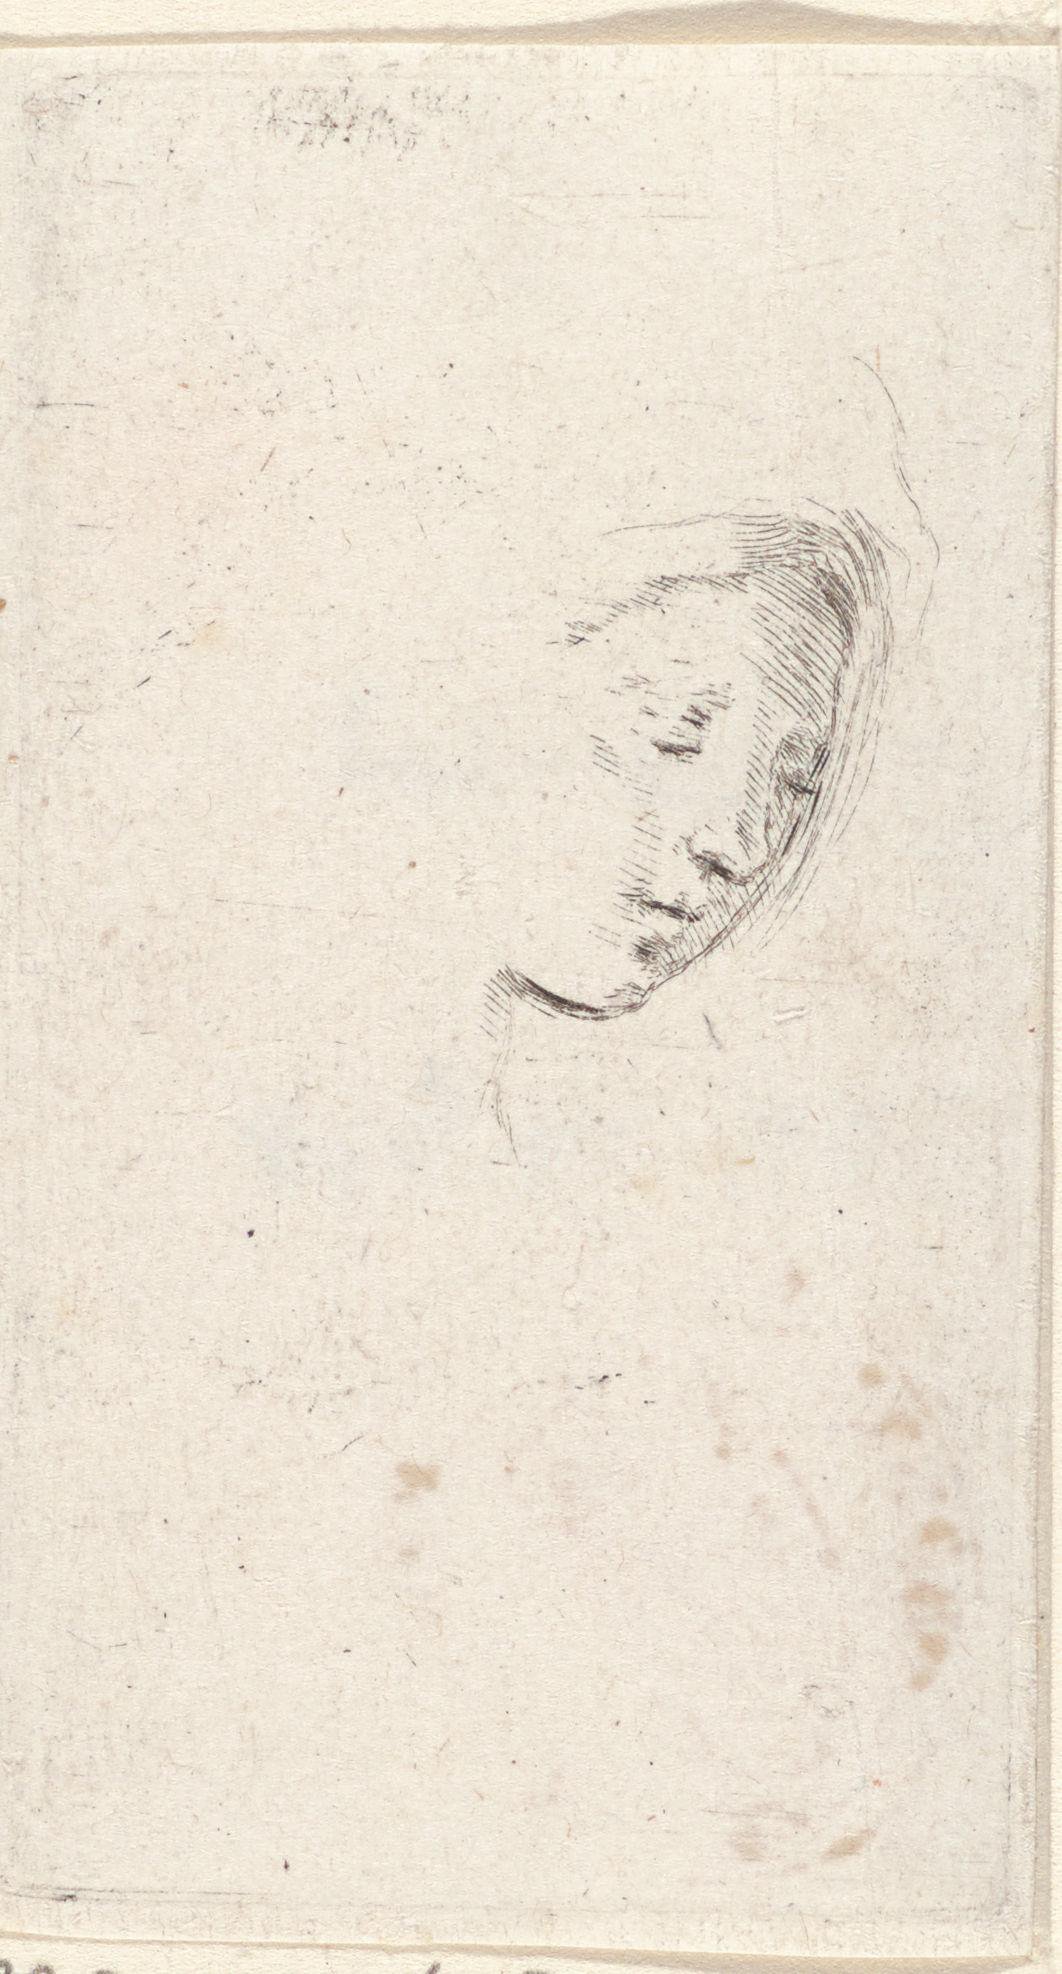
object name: print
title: Recueil de divers griffonnemens et preuves d'eau forte [deel 2]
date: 1620-1664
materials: paper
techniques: etching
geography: paris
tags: adult woman (+ sideview, profile)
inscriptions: collector's mark: Lugt 240